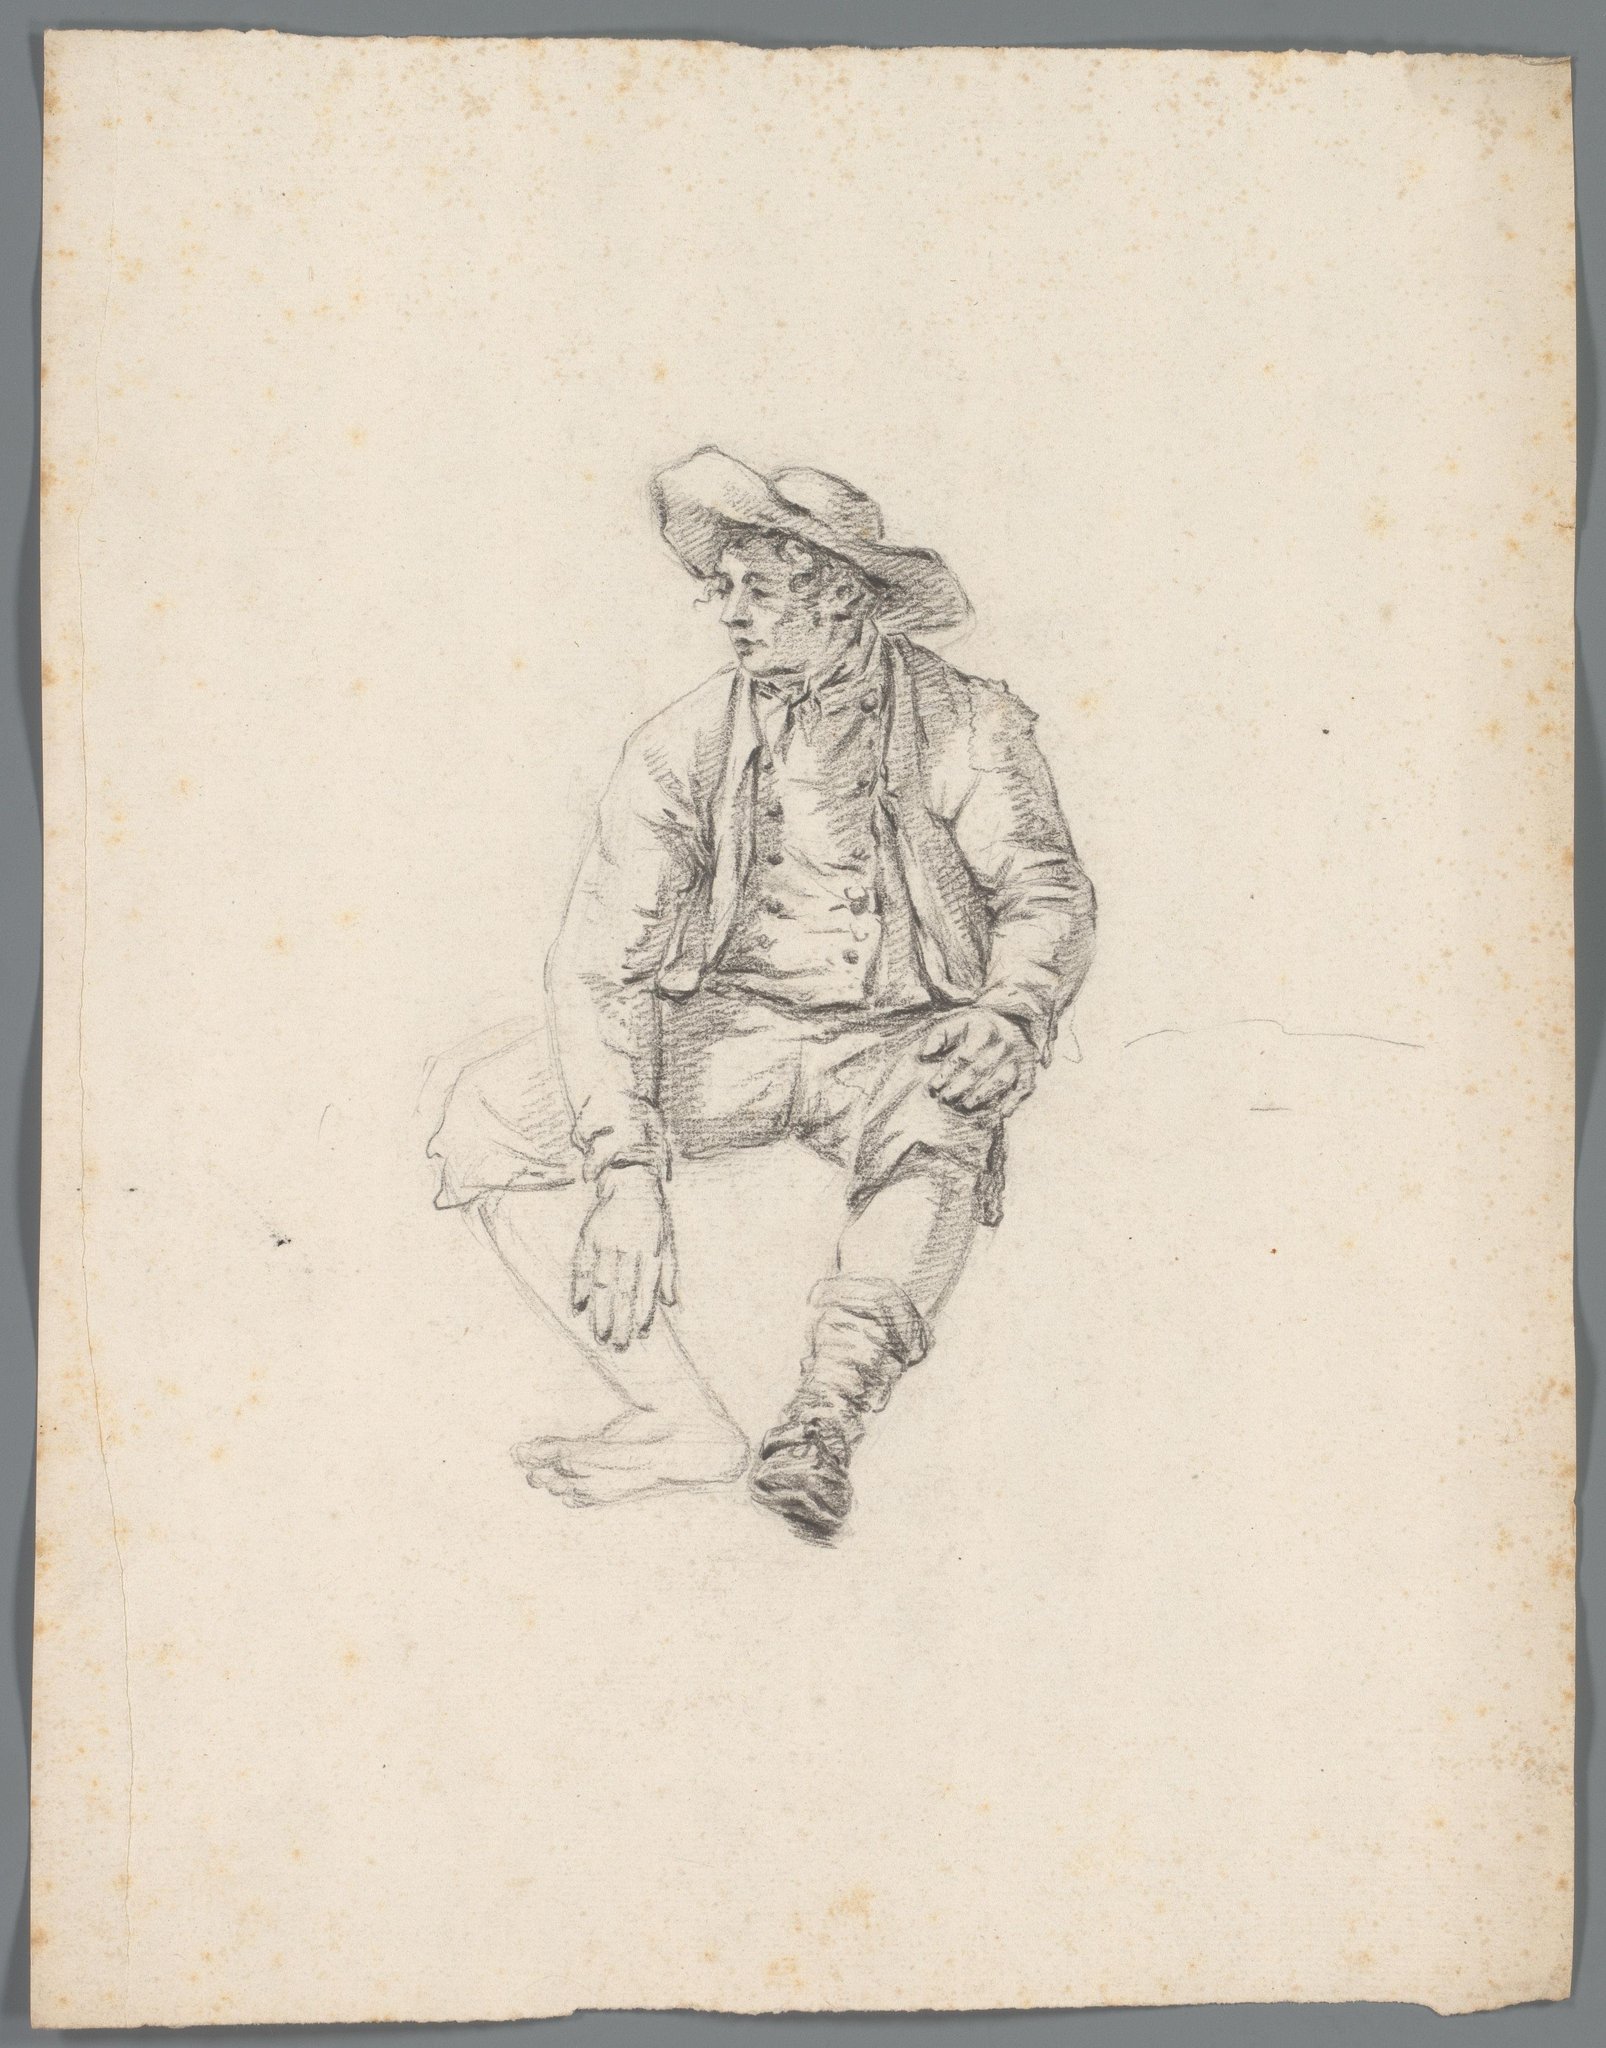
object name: drawing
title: Zittende man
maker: Anonymous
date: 1820-1830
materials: chalk, paper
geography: the hague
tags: sitting figure, adult man, head-gear: hat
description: Tekeningen waarschijnlijk ontstaan bij het Haagse kunstgenootschap ‘Tot Nut der Tekenkunst’, waar twee keer per week tekenavonden werden georganiseerd met geklede modellen.